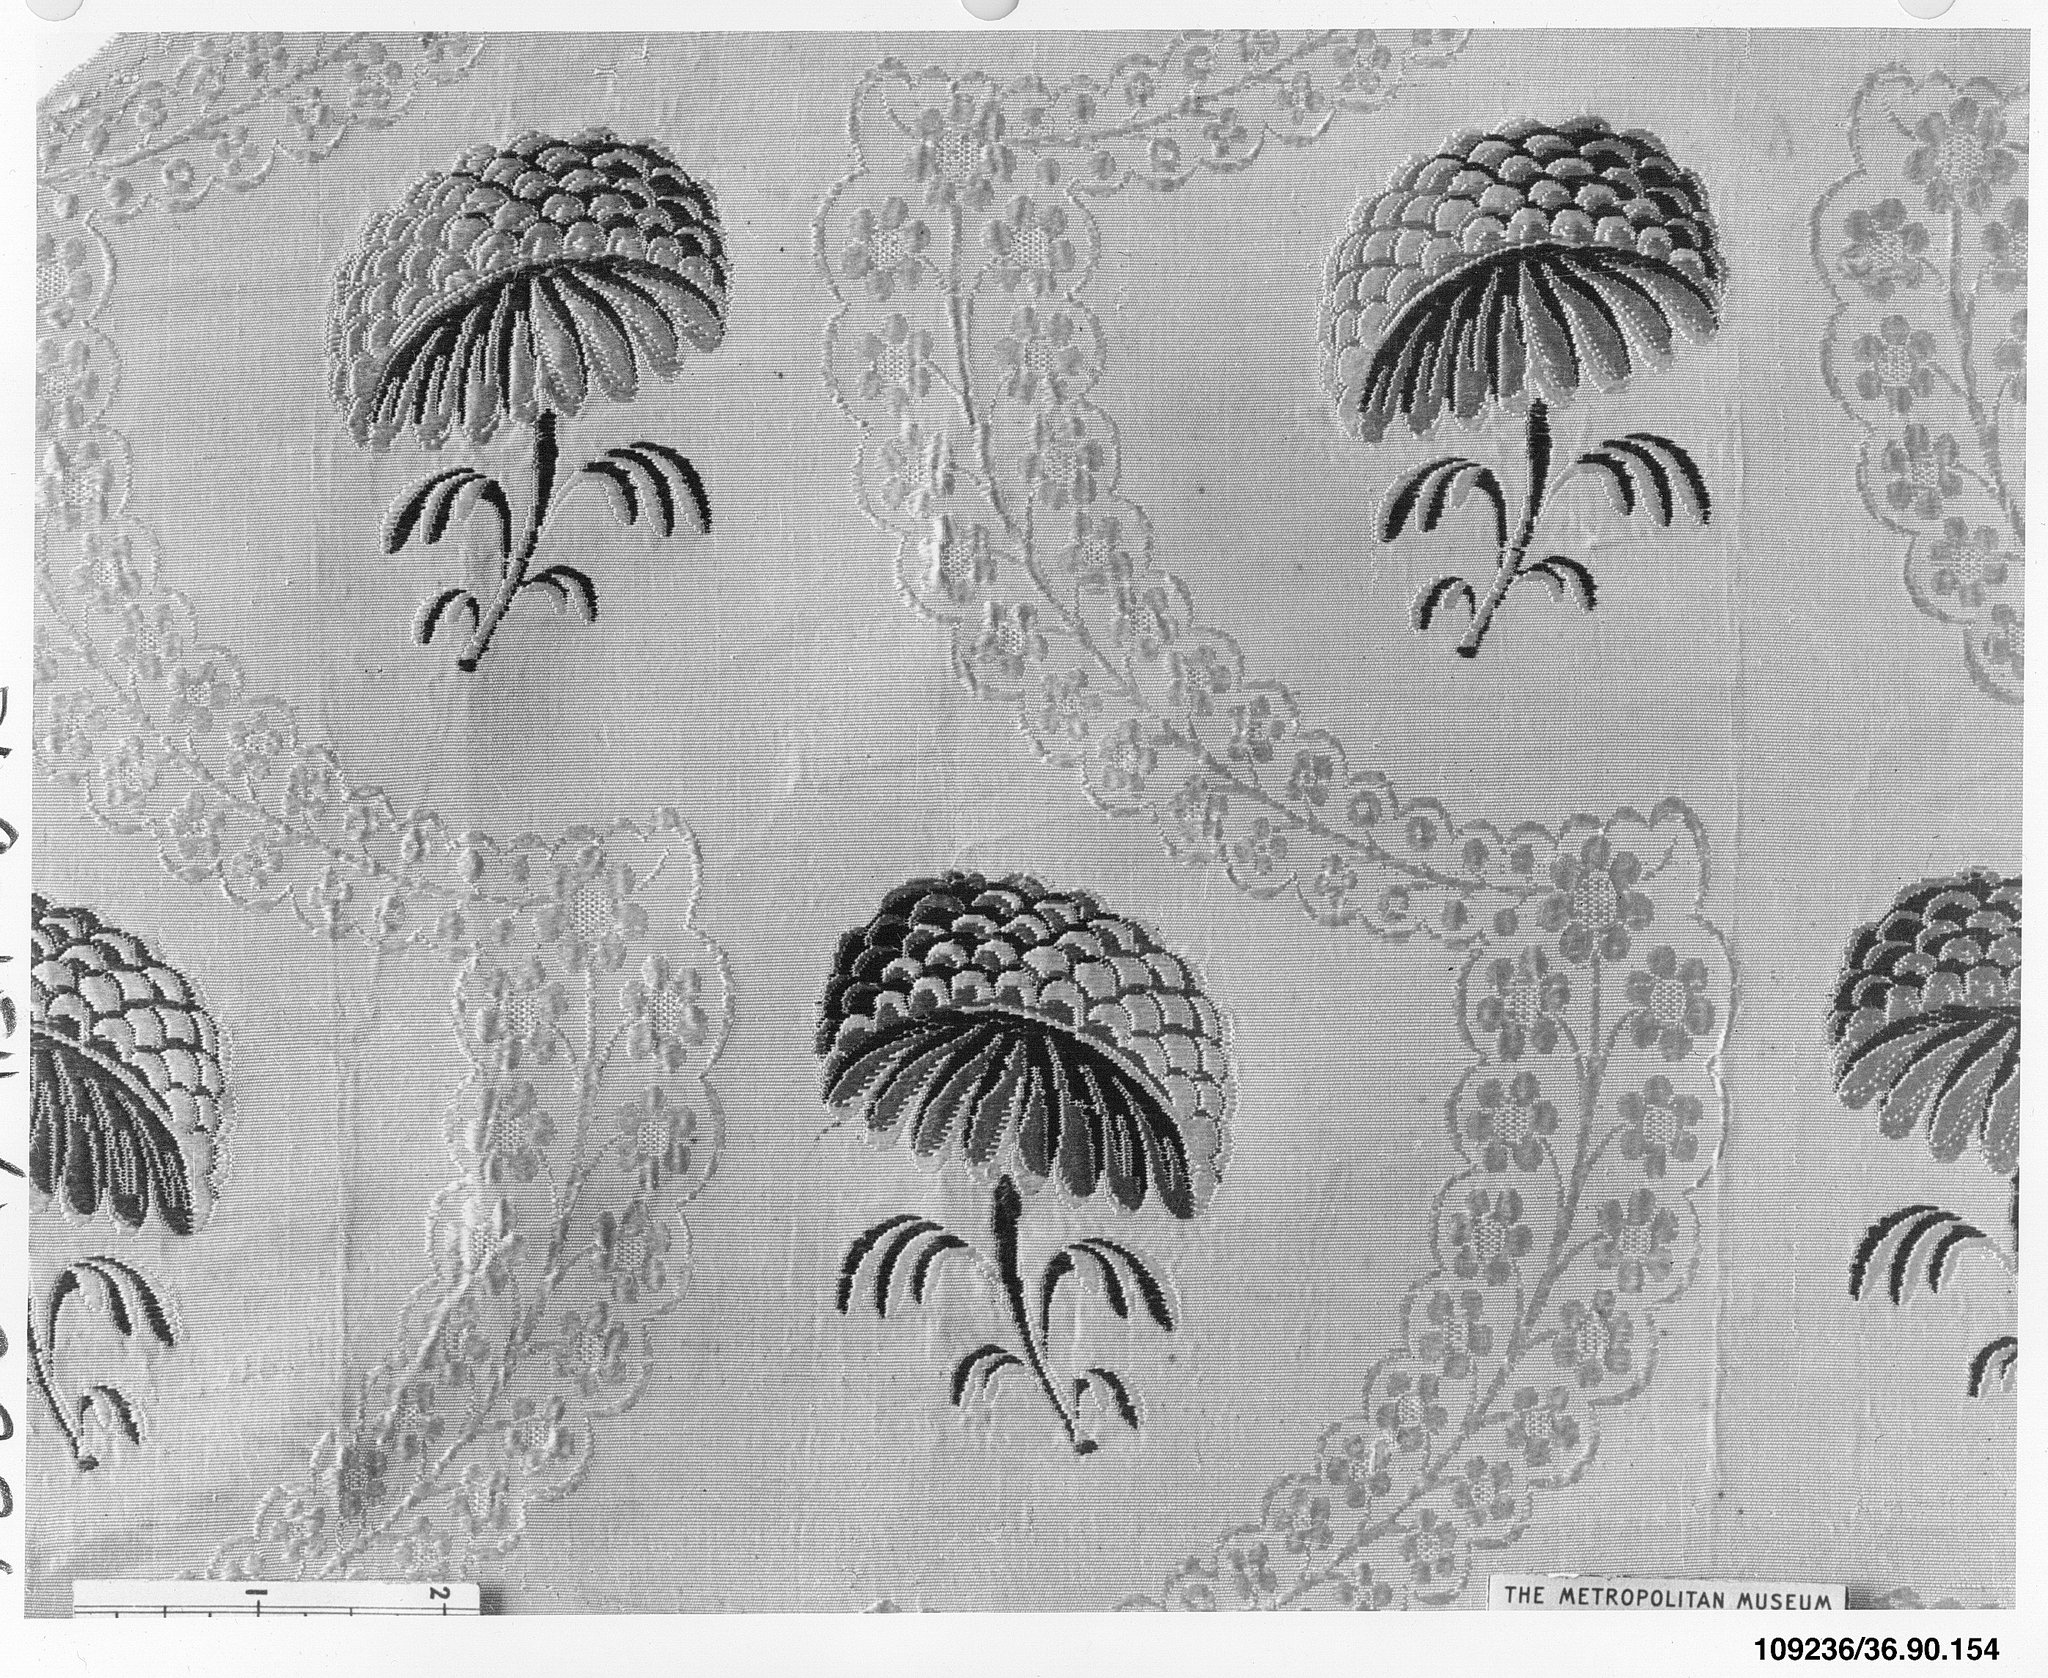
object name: piece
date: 1750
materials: silk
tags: flowers